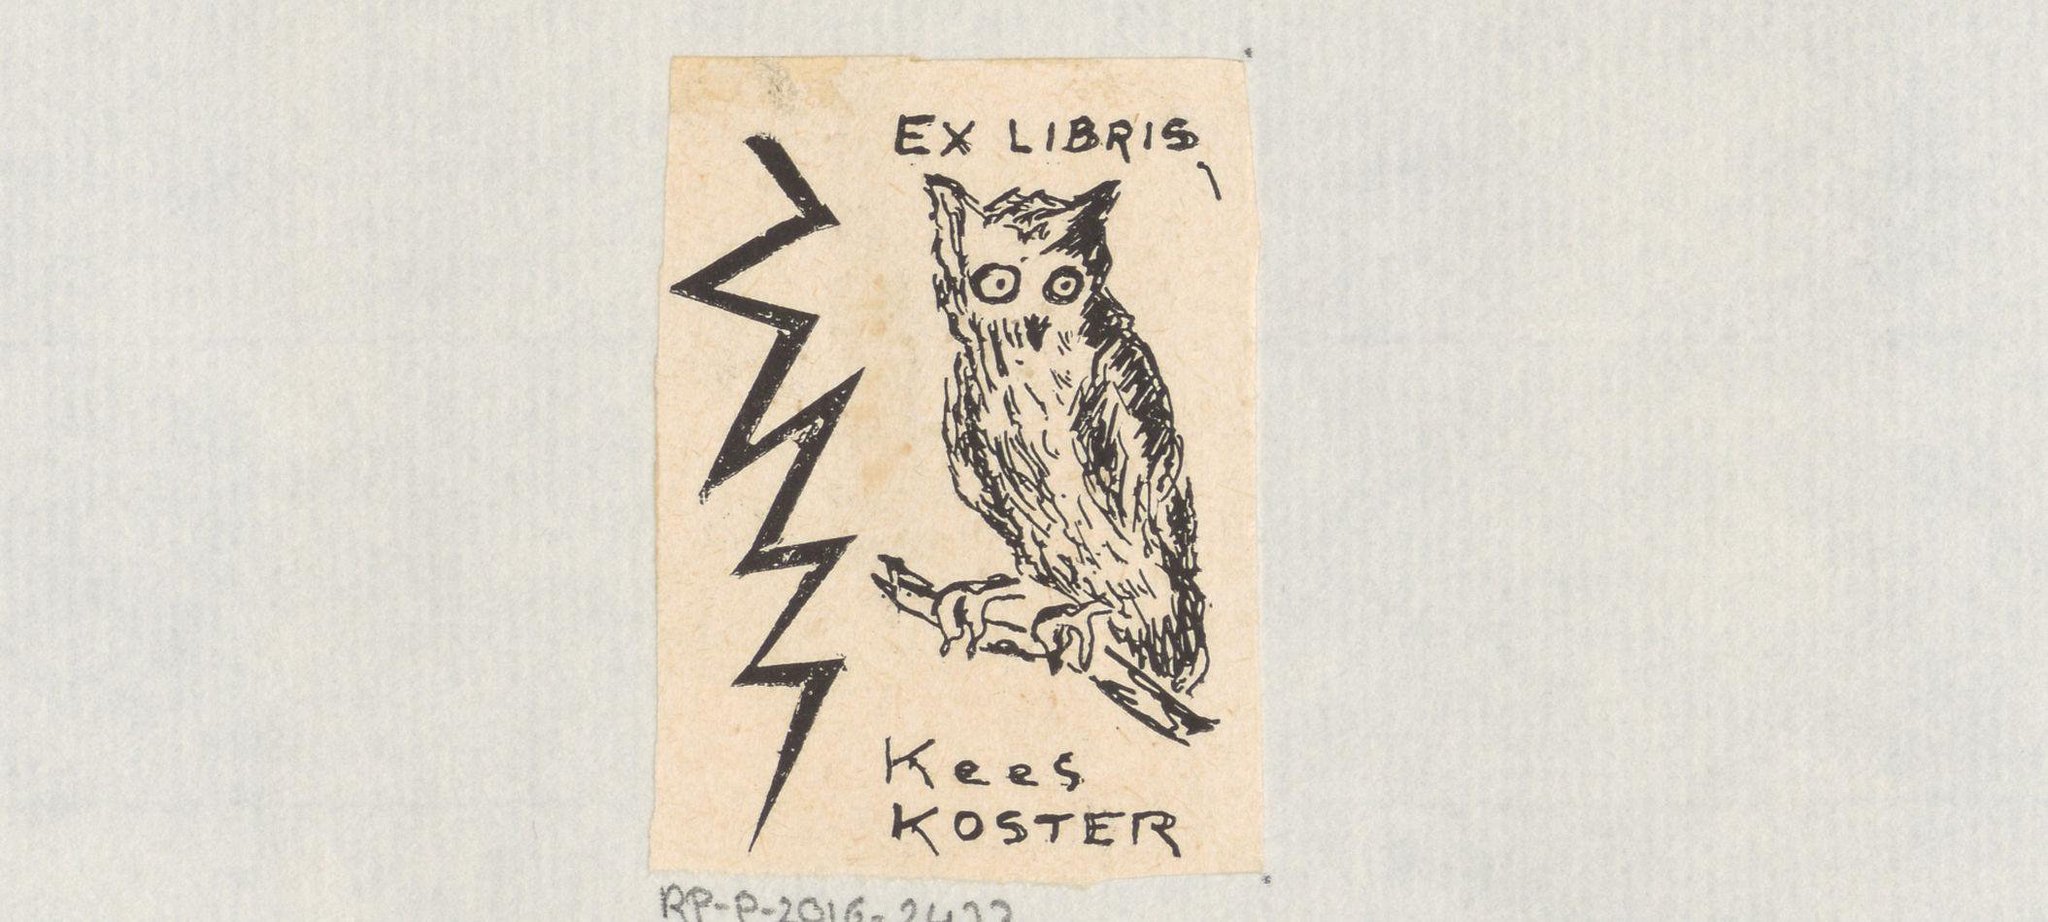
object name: bookplate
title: Ex libris van Kees Koster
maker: c. bregman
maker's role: print maker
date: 1900-1999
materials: paper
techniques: printing block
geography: netherlands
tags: thunder, owls